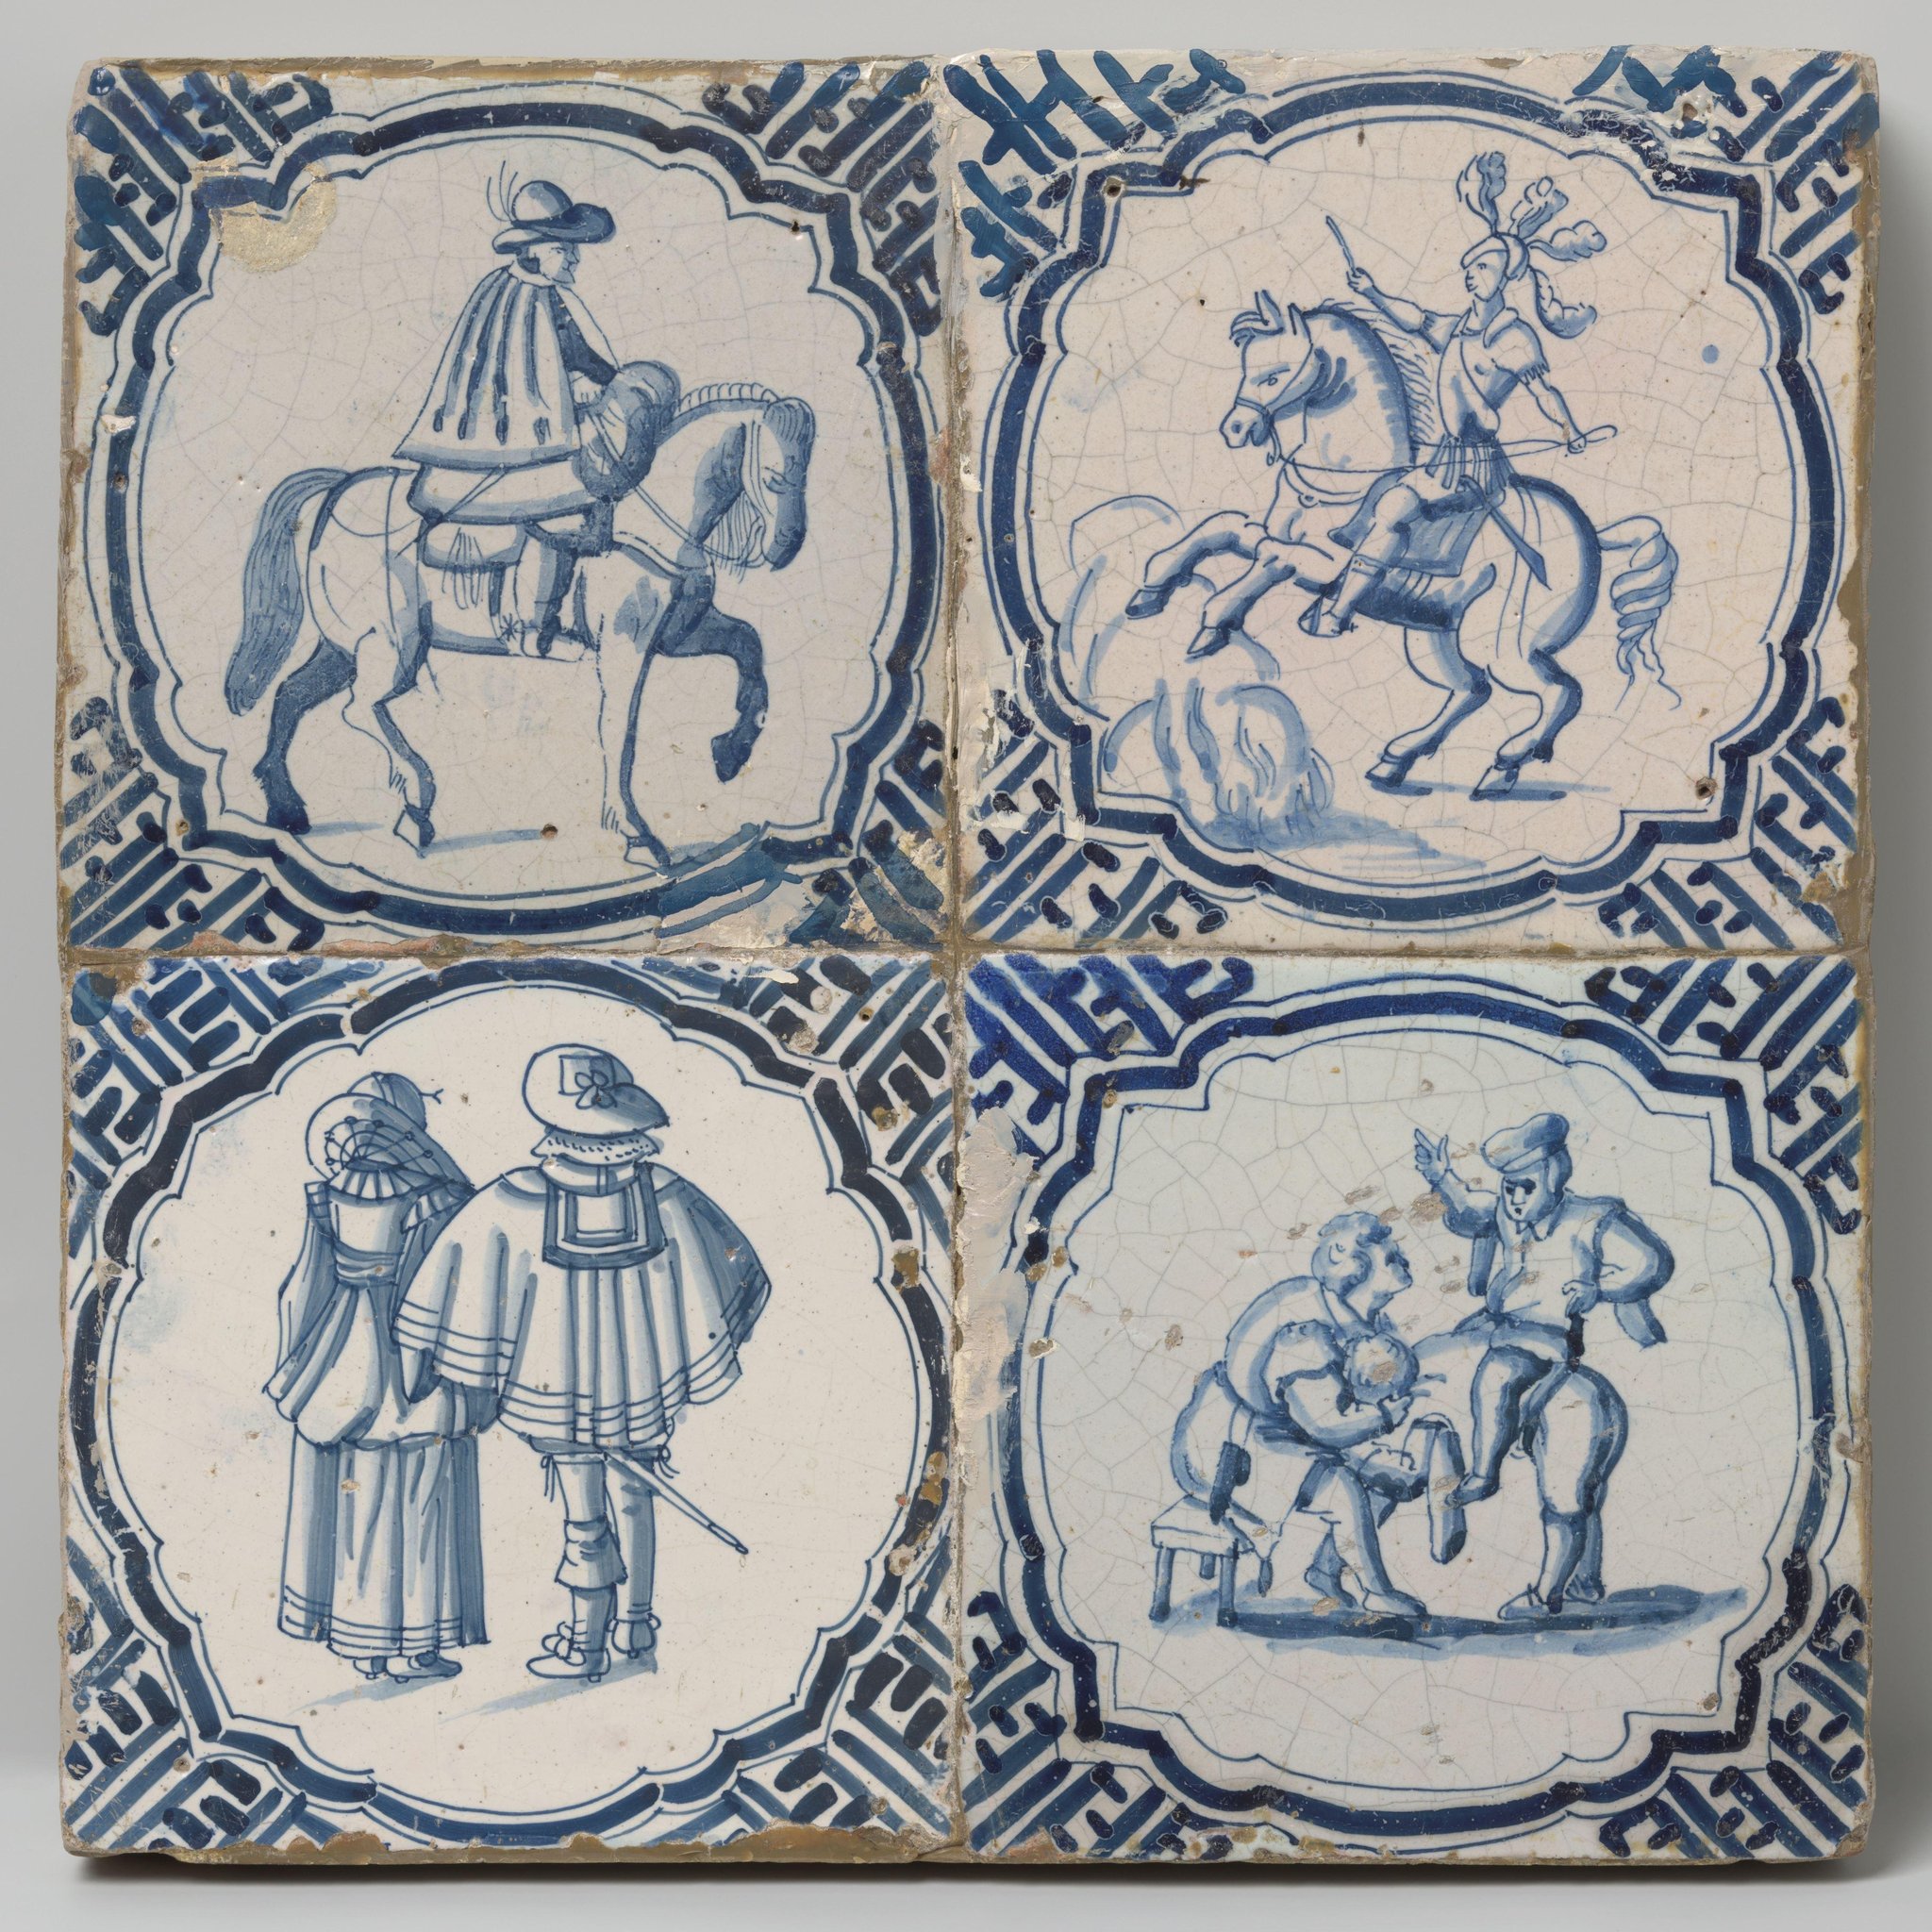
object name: tile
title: Veld van vier tegels met mensen en hun bezigheden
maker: Anonymous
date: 1620-1640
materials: earthenware, glaze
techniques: maiolica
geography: netherlands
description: Veld van vier tegels (2 x 2) elk met een blauw geschilderde man, vrouw of meerdere figuren verdiept in allerlei bezigheden binnen een cirkel met geschulpte rand. In de hoeken, meander ornament.